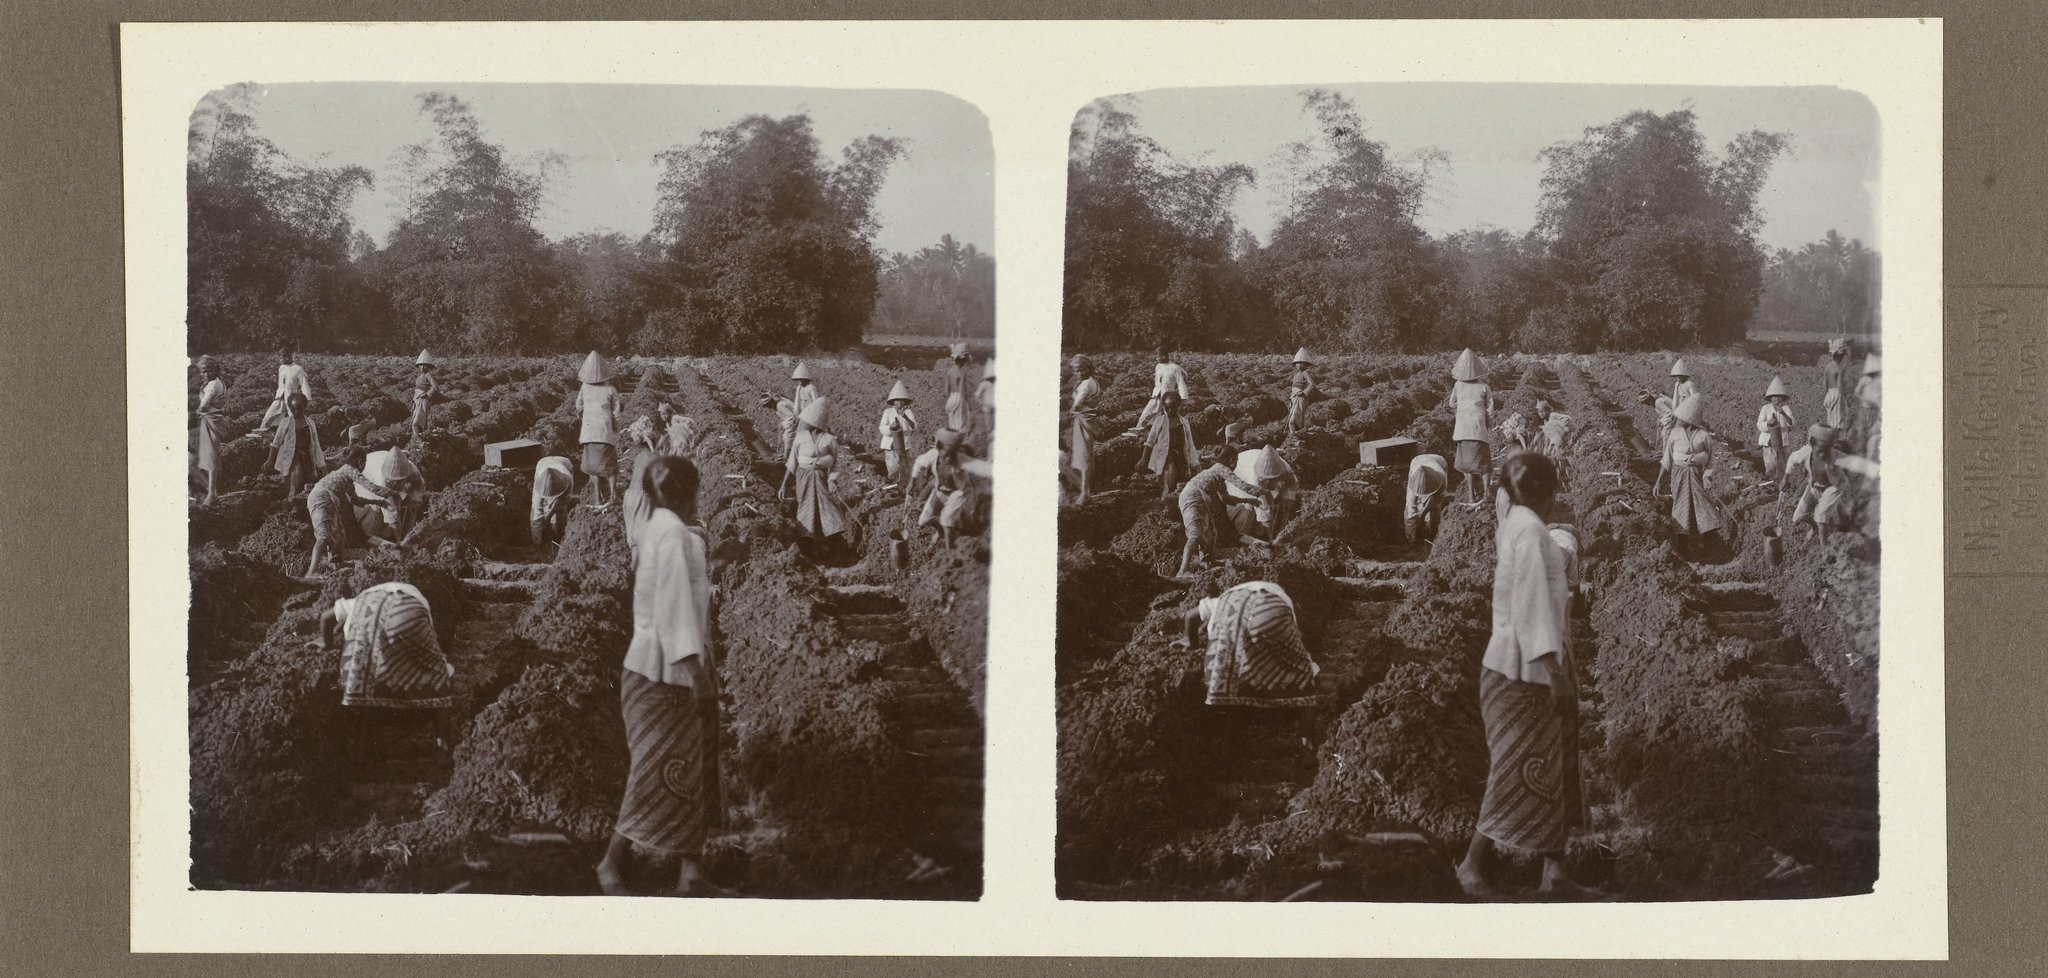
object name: stereograph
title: Bewerken van de plantgeulen voor het planten van suiker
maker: neville keasberry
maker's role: fotograaf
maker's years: 1866-1944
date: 1900-1935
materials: cardboard, paper, photographic support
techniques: albumen print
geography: malang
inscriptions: title: ‘S 1 No 3. Suikercultuur. Begieten van plantgeulen.’, signature: ‘Neville Keasberry, Malang (Java)’